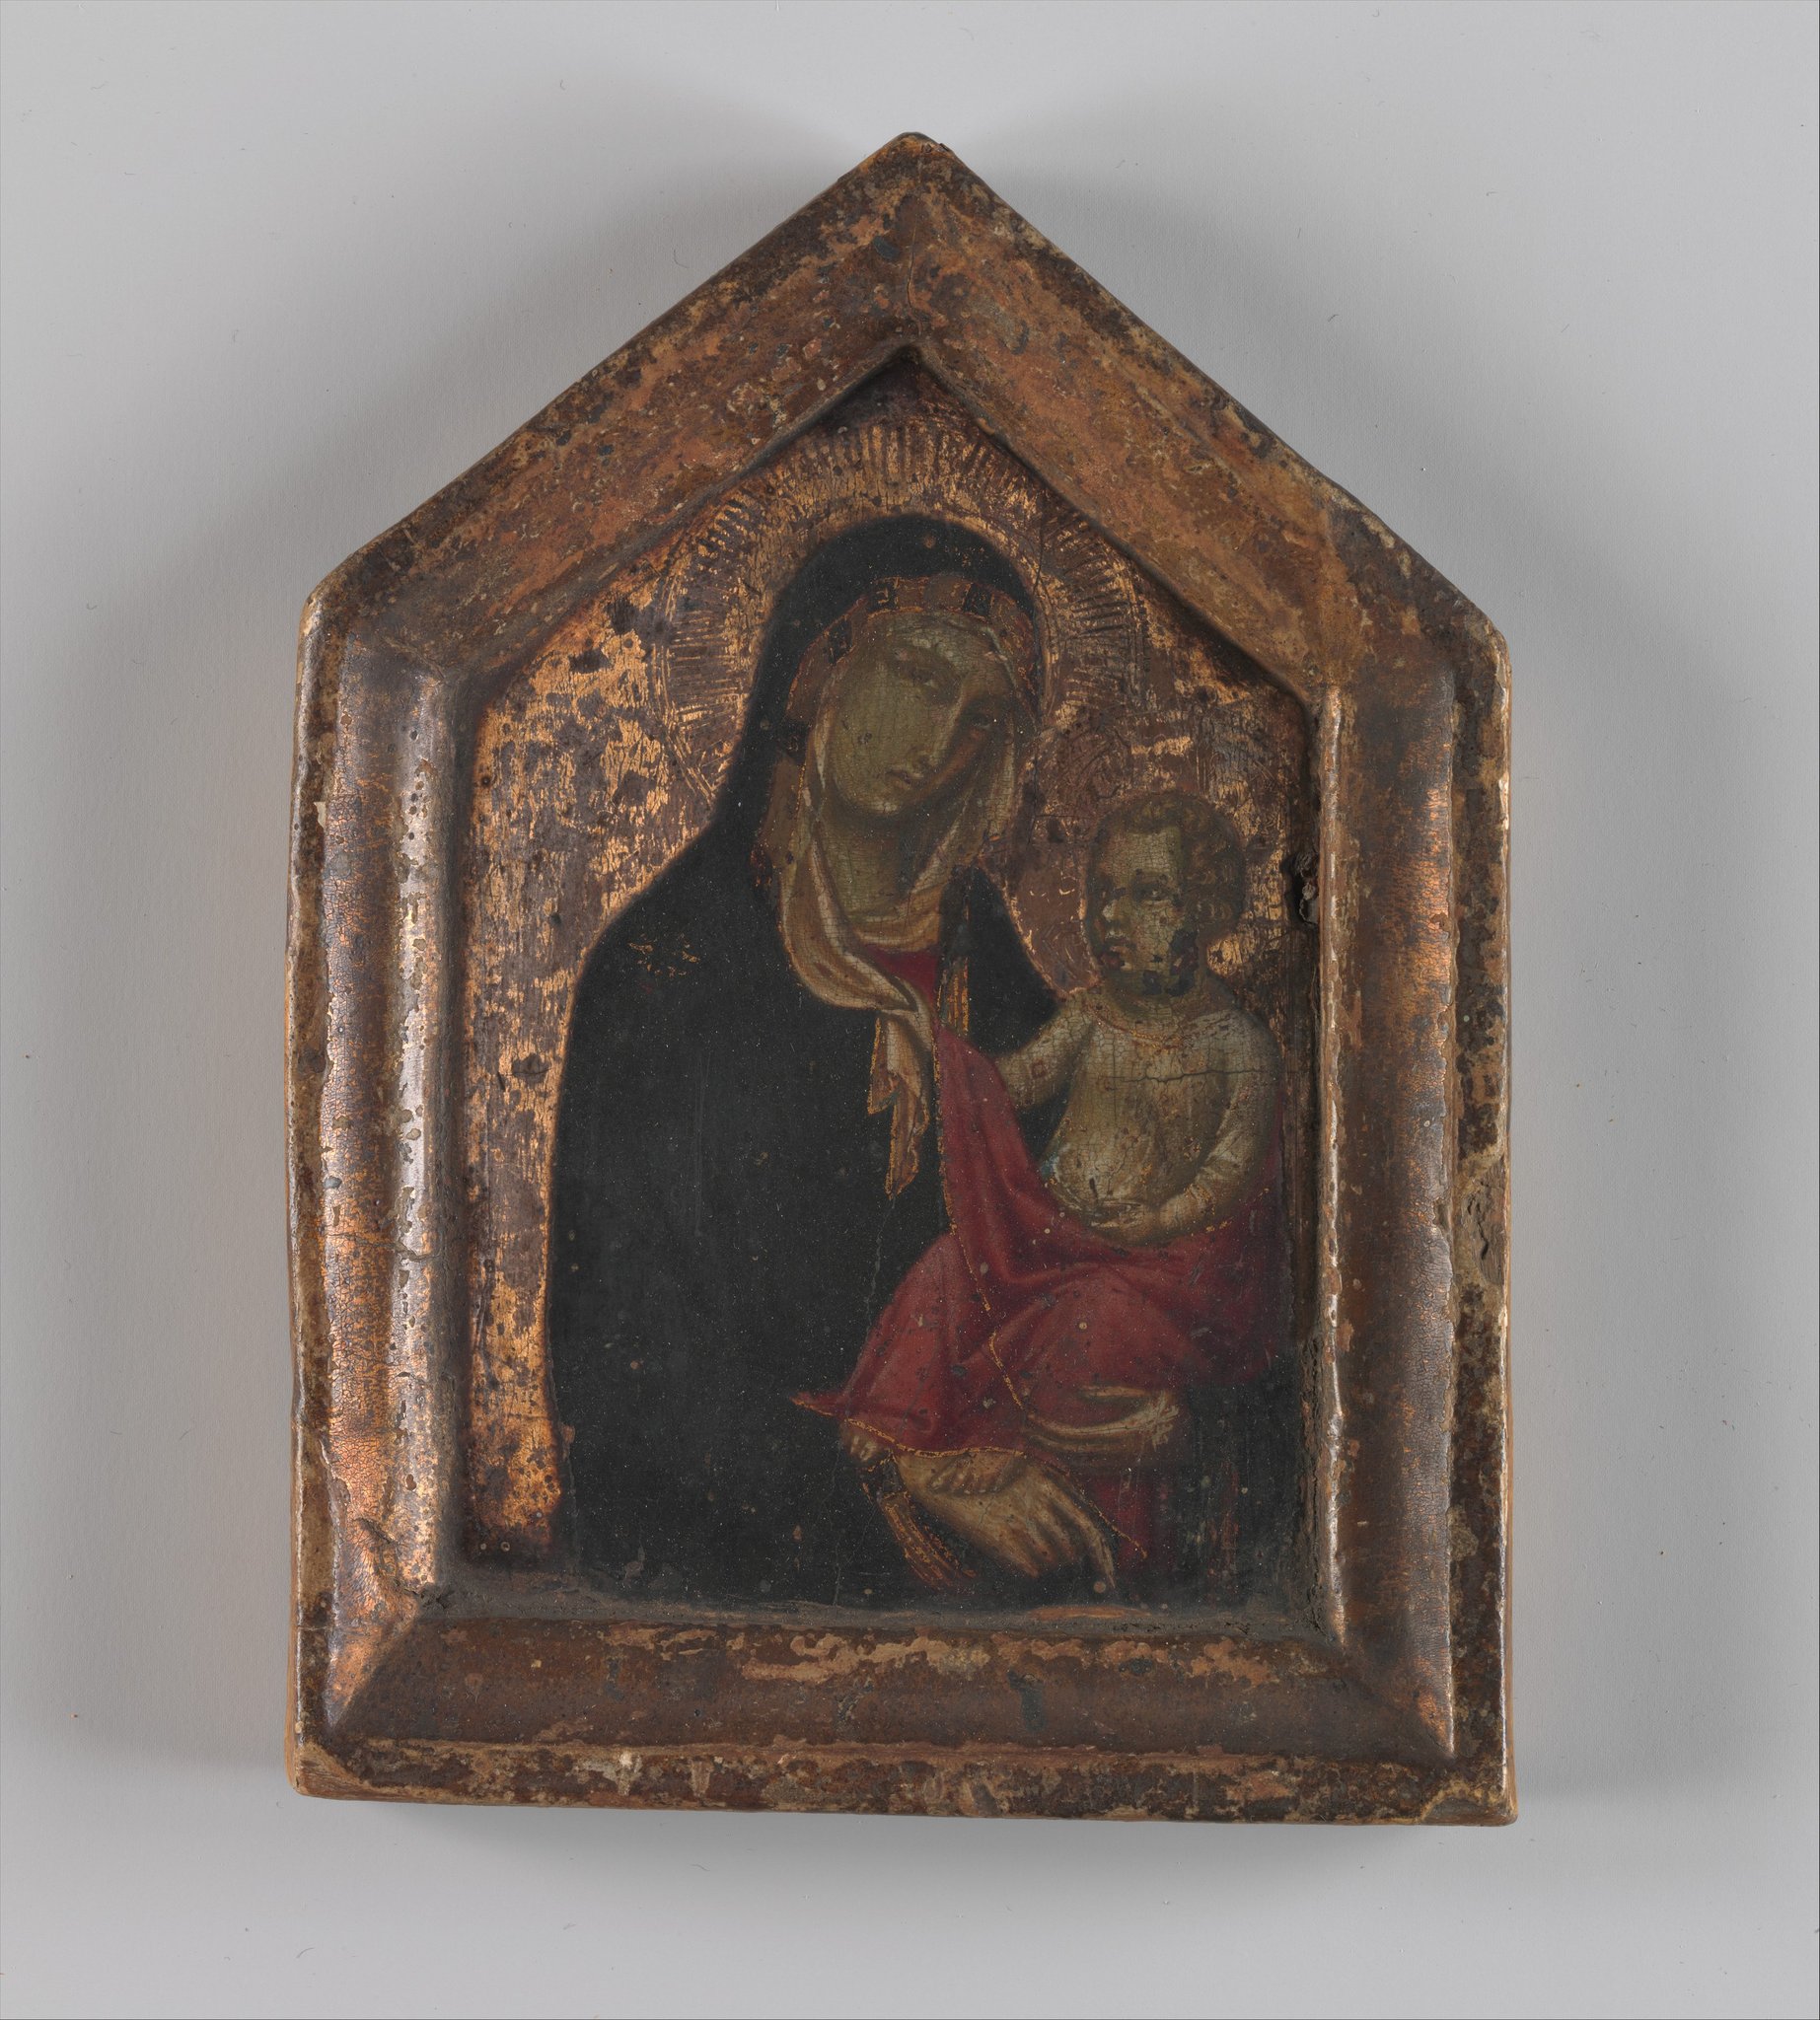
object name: frame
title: Engaged diptych moldings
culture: italian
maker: tuscany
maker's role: artist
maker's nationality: tuscany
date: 1300-1325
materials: wood